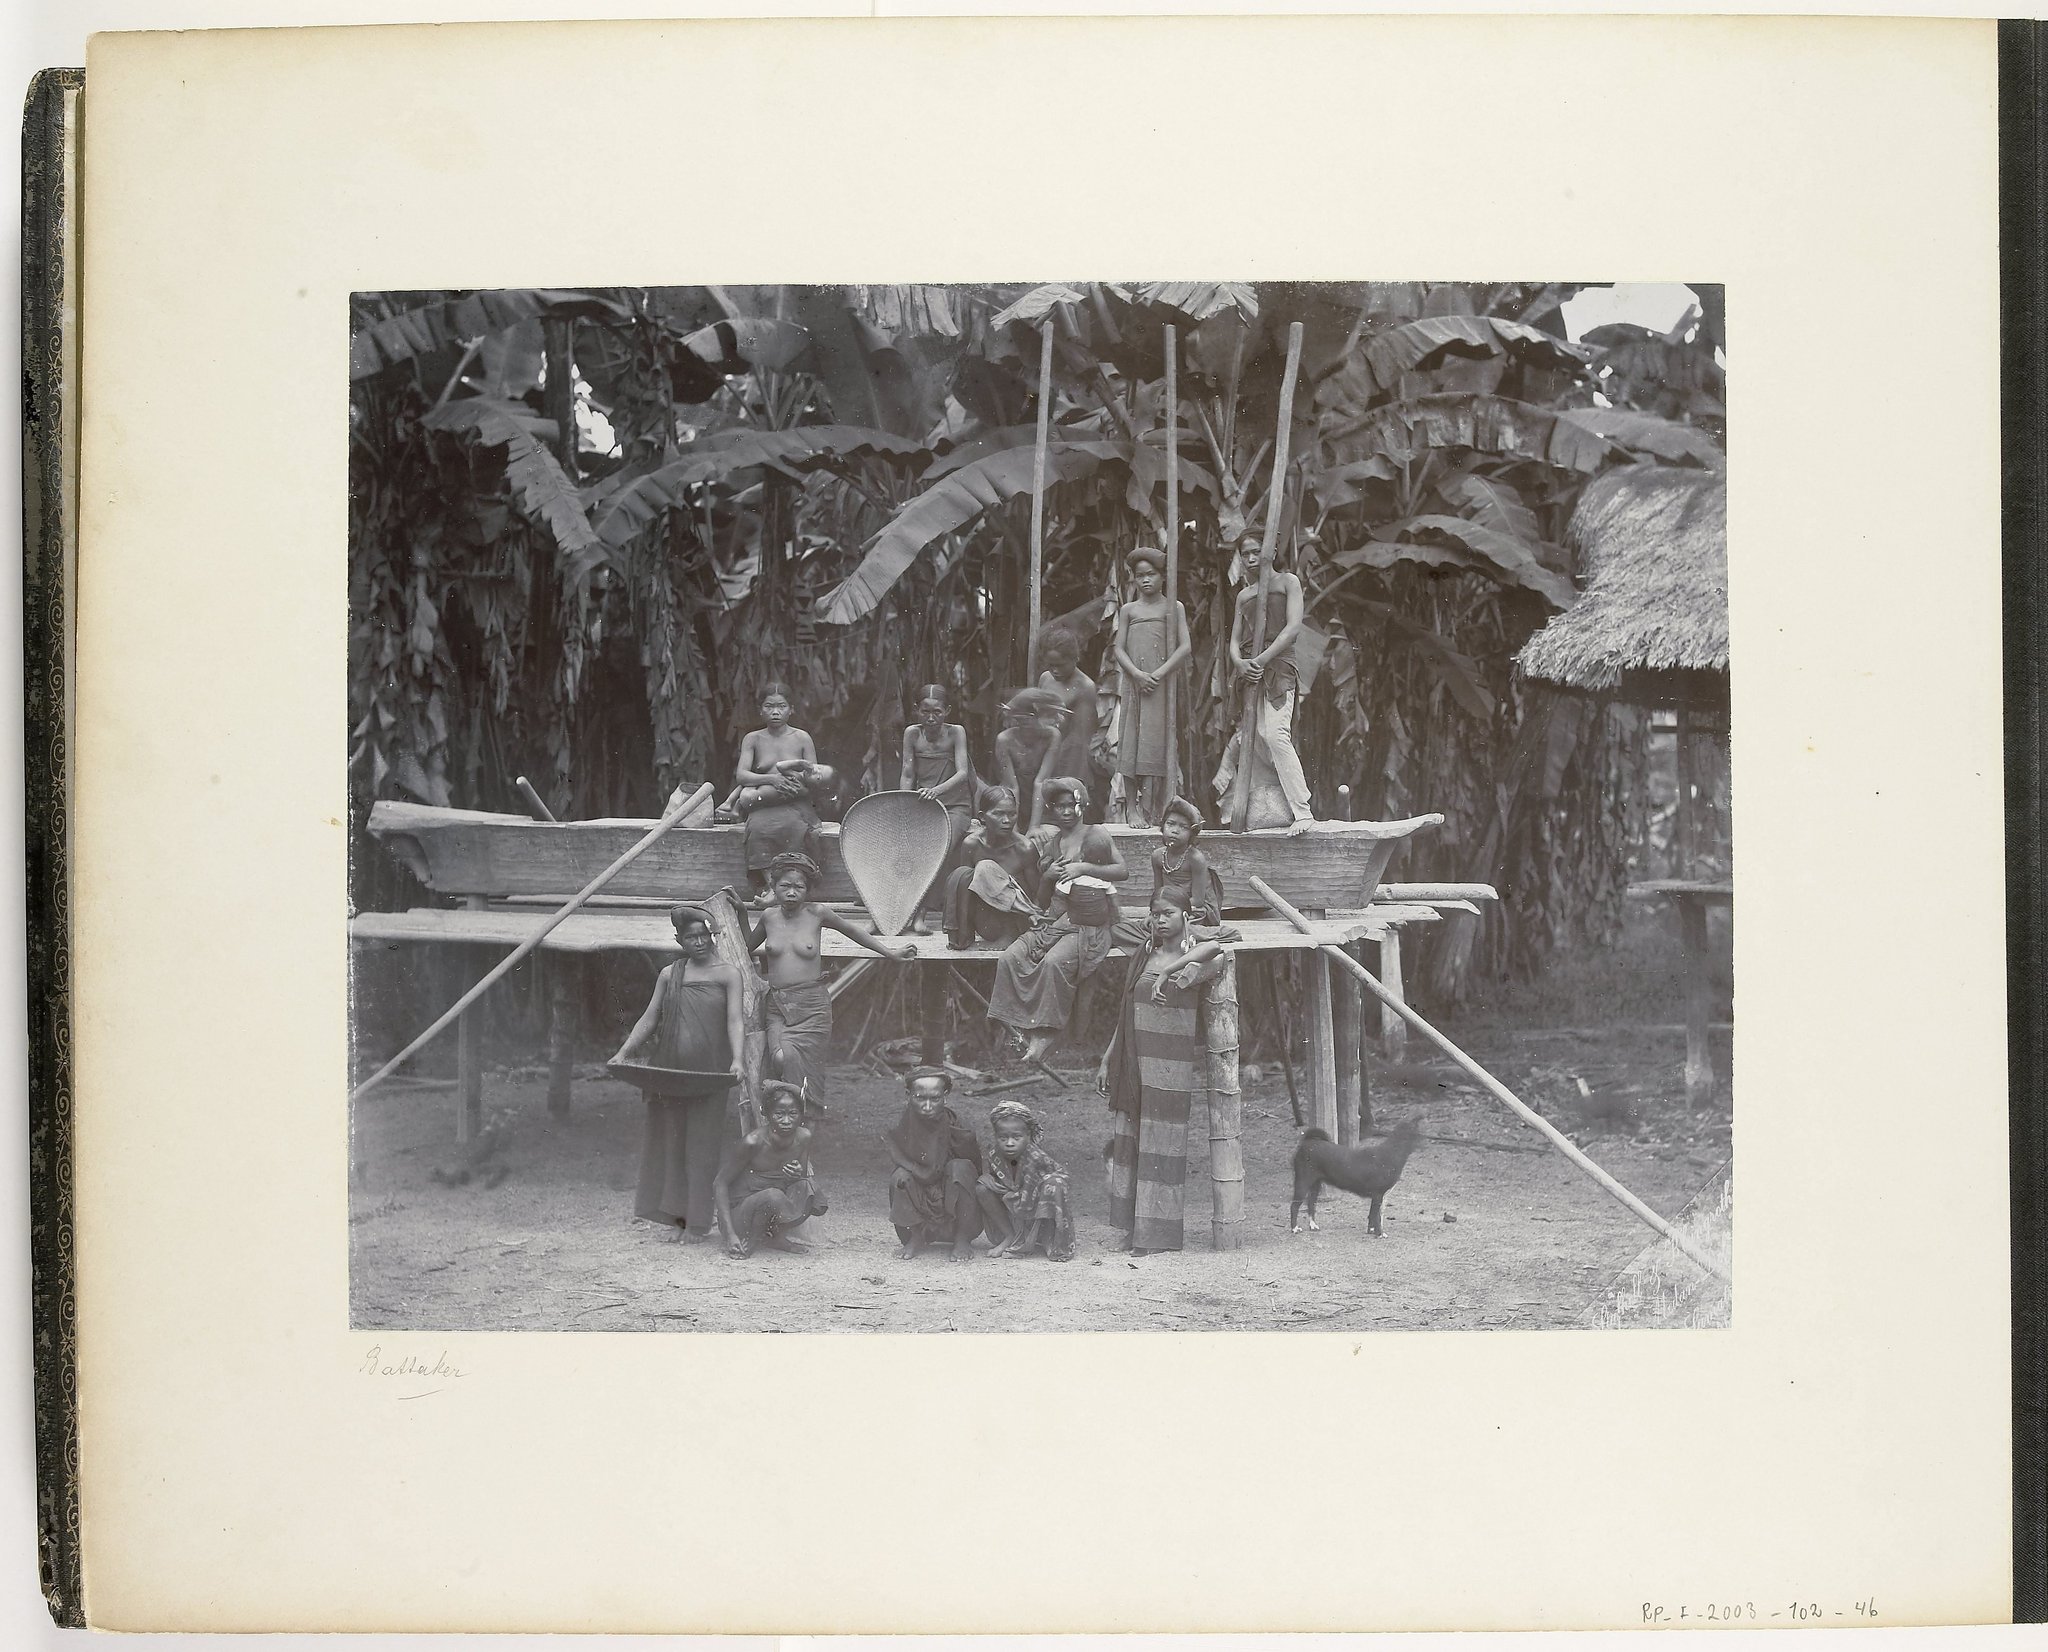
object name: photograph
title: Groepsportret van Batakse vrouwen met werktuigen voor het rijst stampen, Sumatra (Battakfrauen, Reis stampfend)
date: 1890-1895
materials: photographic support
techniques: collodion silver print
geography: sumatra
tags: sumatra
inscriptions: signature: ‘Stafhell & Kleingrothe Medan-Deli’, number: ‘Sumatra 16’, inscription: ‘Battaker’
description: Batak vrouwen en kinderen bezig met het stampen van rijst. Onderdeel van het Sumatra fotoalbum van Paul en Lucie Sandel uit 1900.